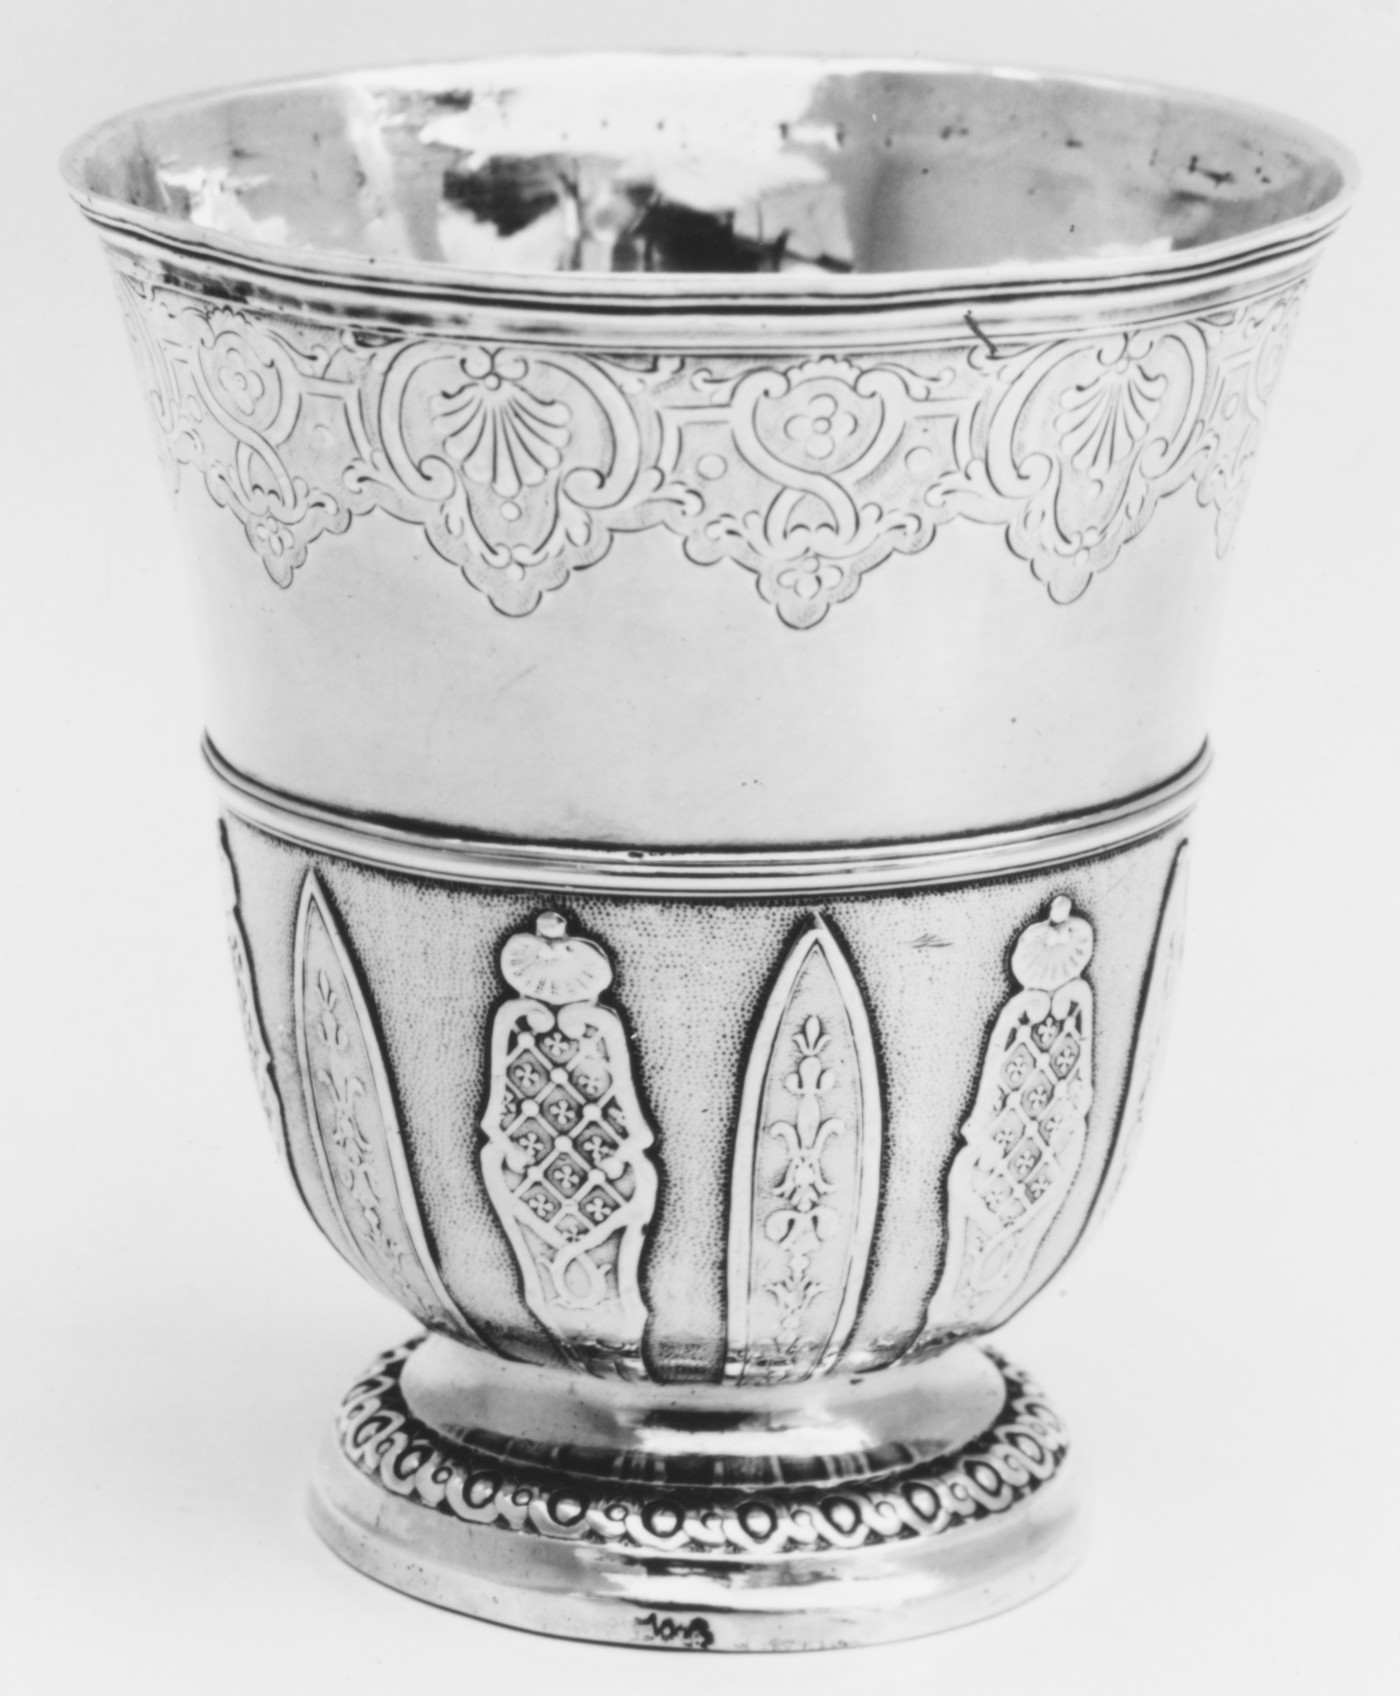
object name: beaker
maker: etienne guiart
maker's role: maker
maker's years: 1682-1742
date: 1701-1750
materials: silver